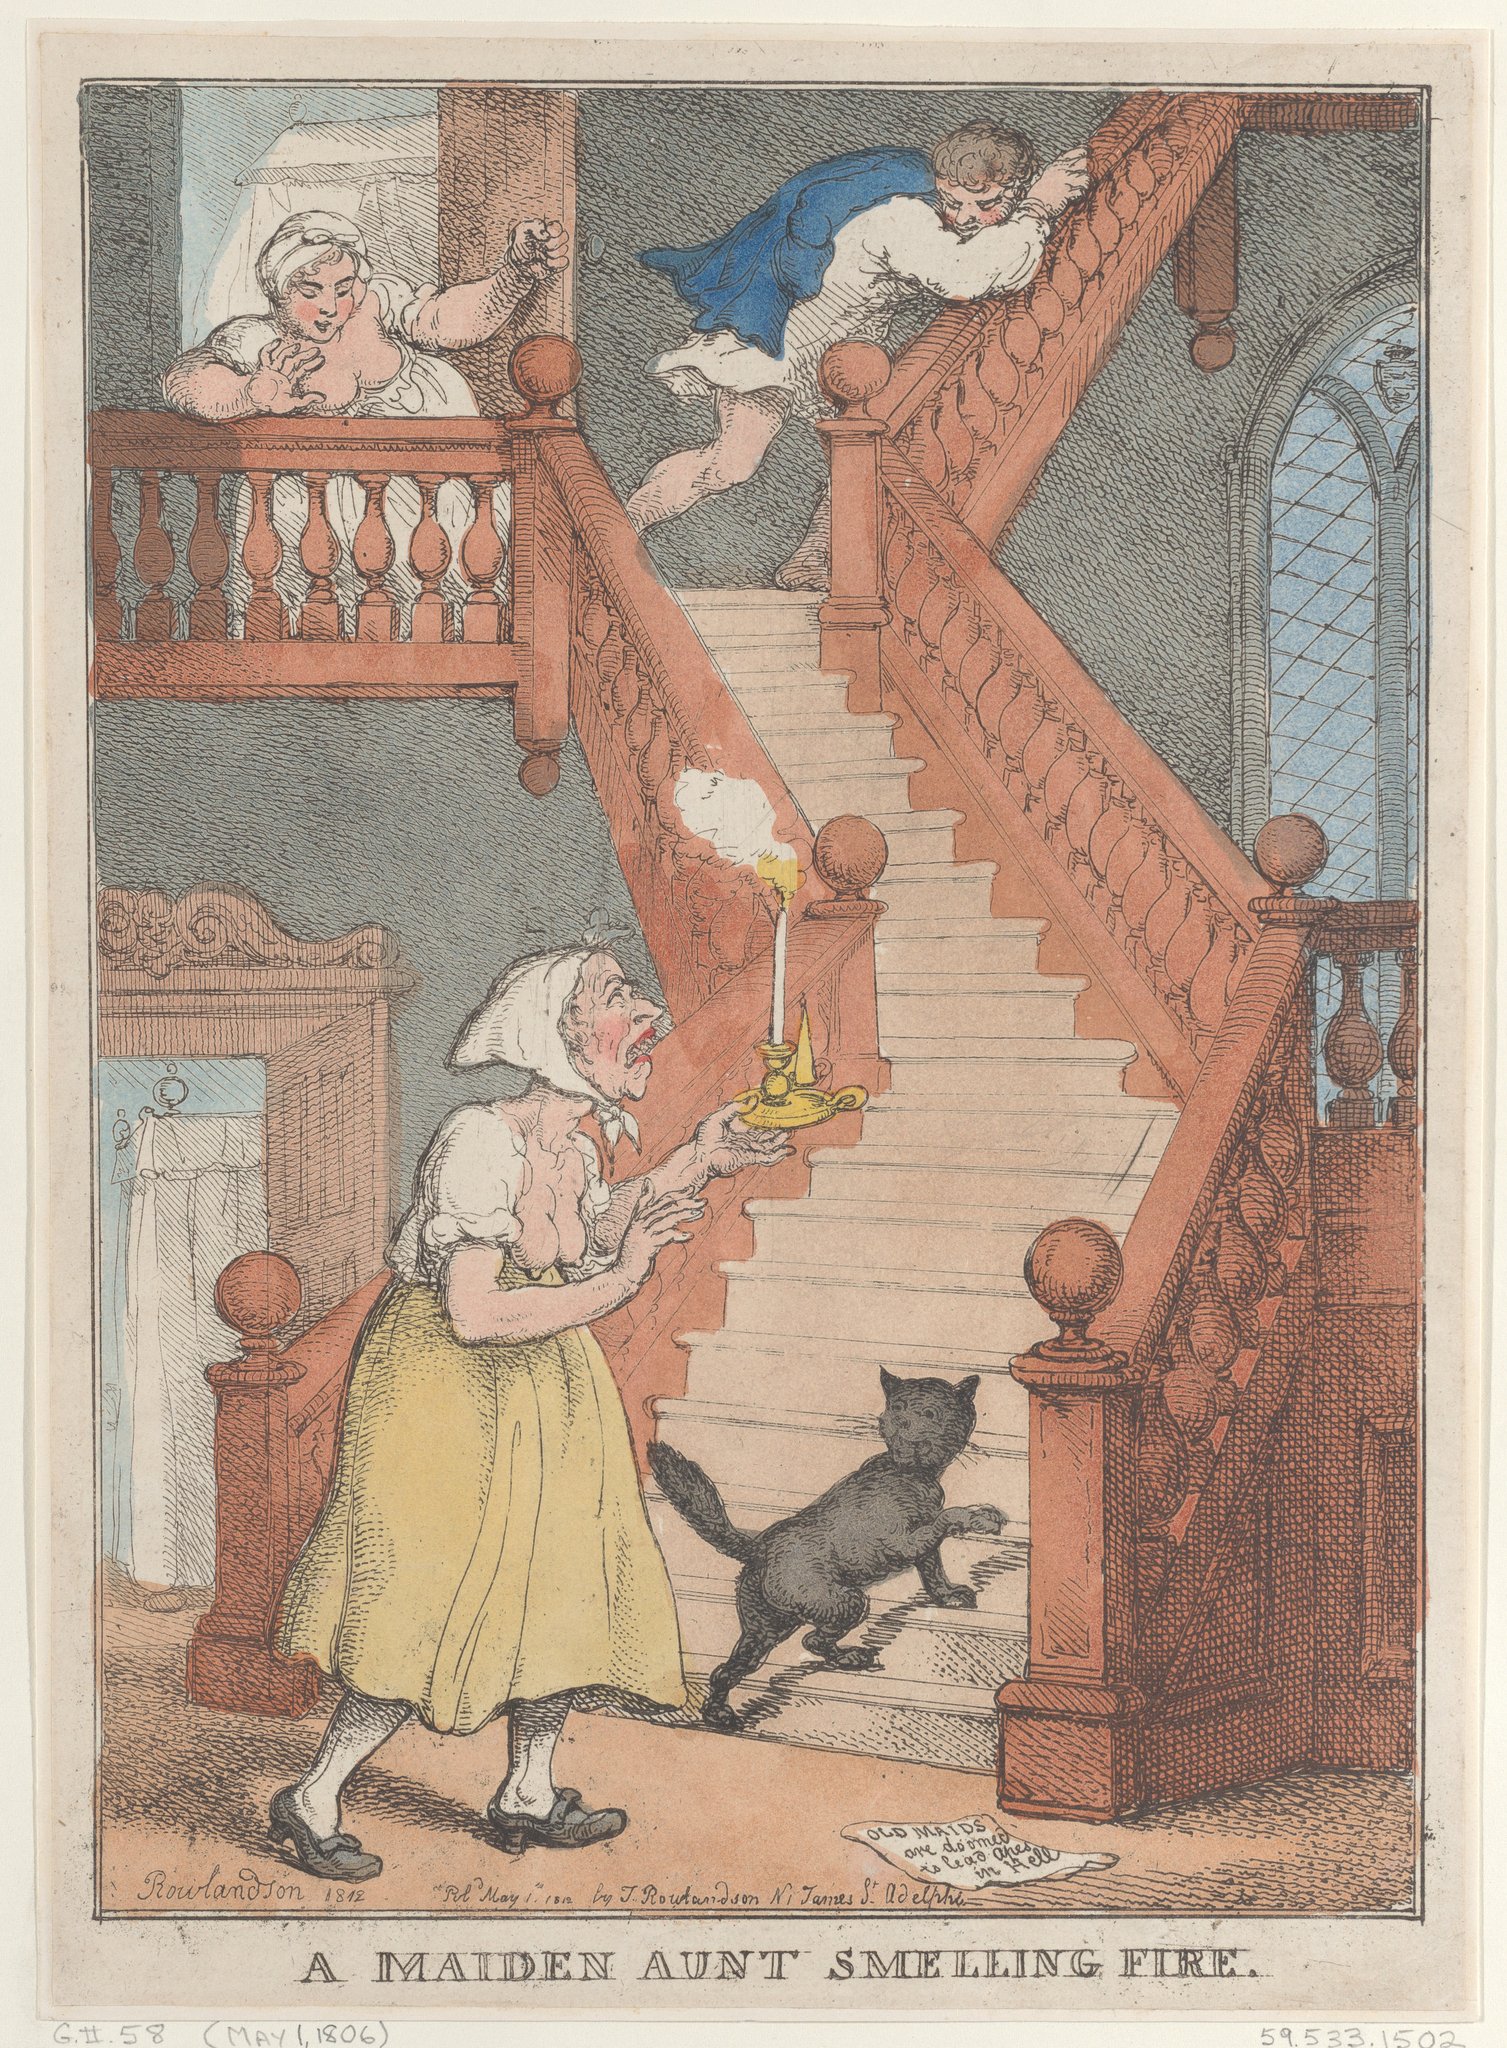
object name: print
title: A Maiden Aunt Smelling Fire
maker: thomas rowlandson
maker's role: artist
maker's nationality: british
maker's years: 1757-1827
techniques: etching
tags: satire,men,women,cats